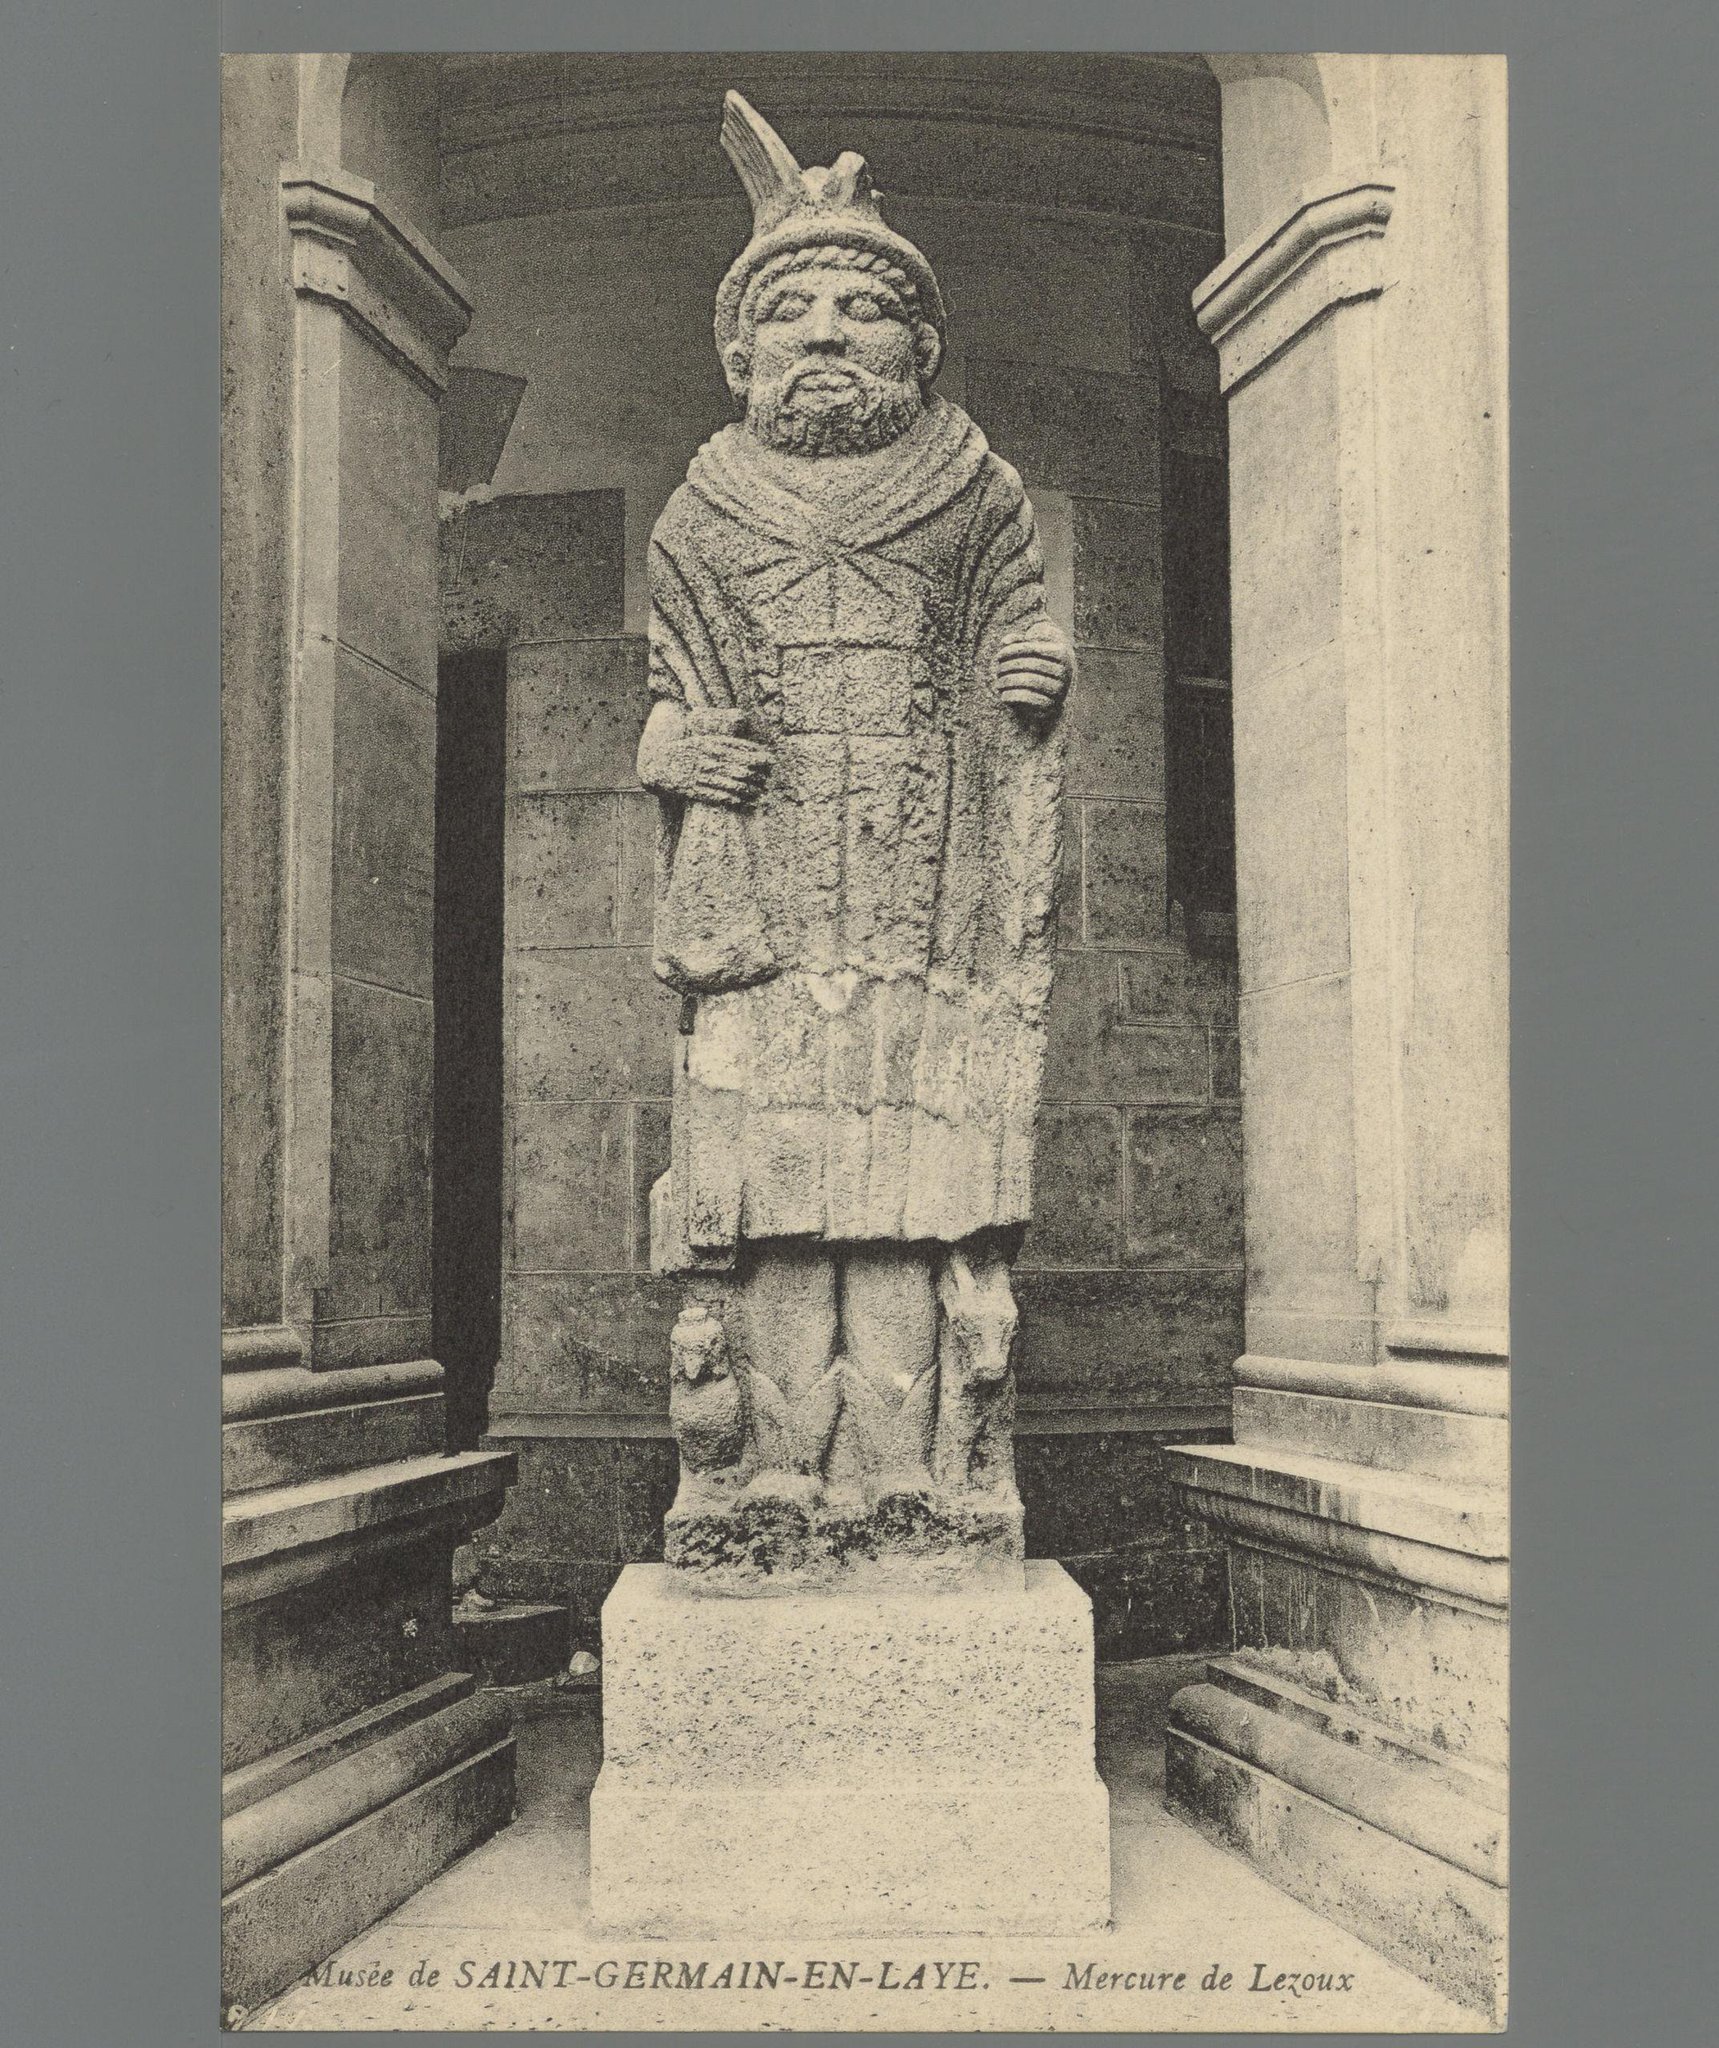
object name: photomechanical print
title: Mercure de Lezoux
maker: Anonymous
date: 1820-1903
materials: cardboard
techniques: photograph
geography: saint-germain-en-laye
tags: monument, statue, permanent exhibition, museum